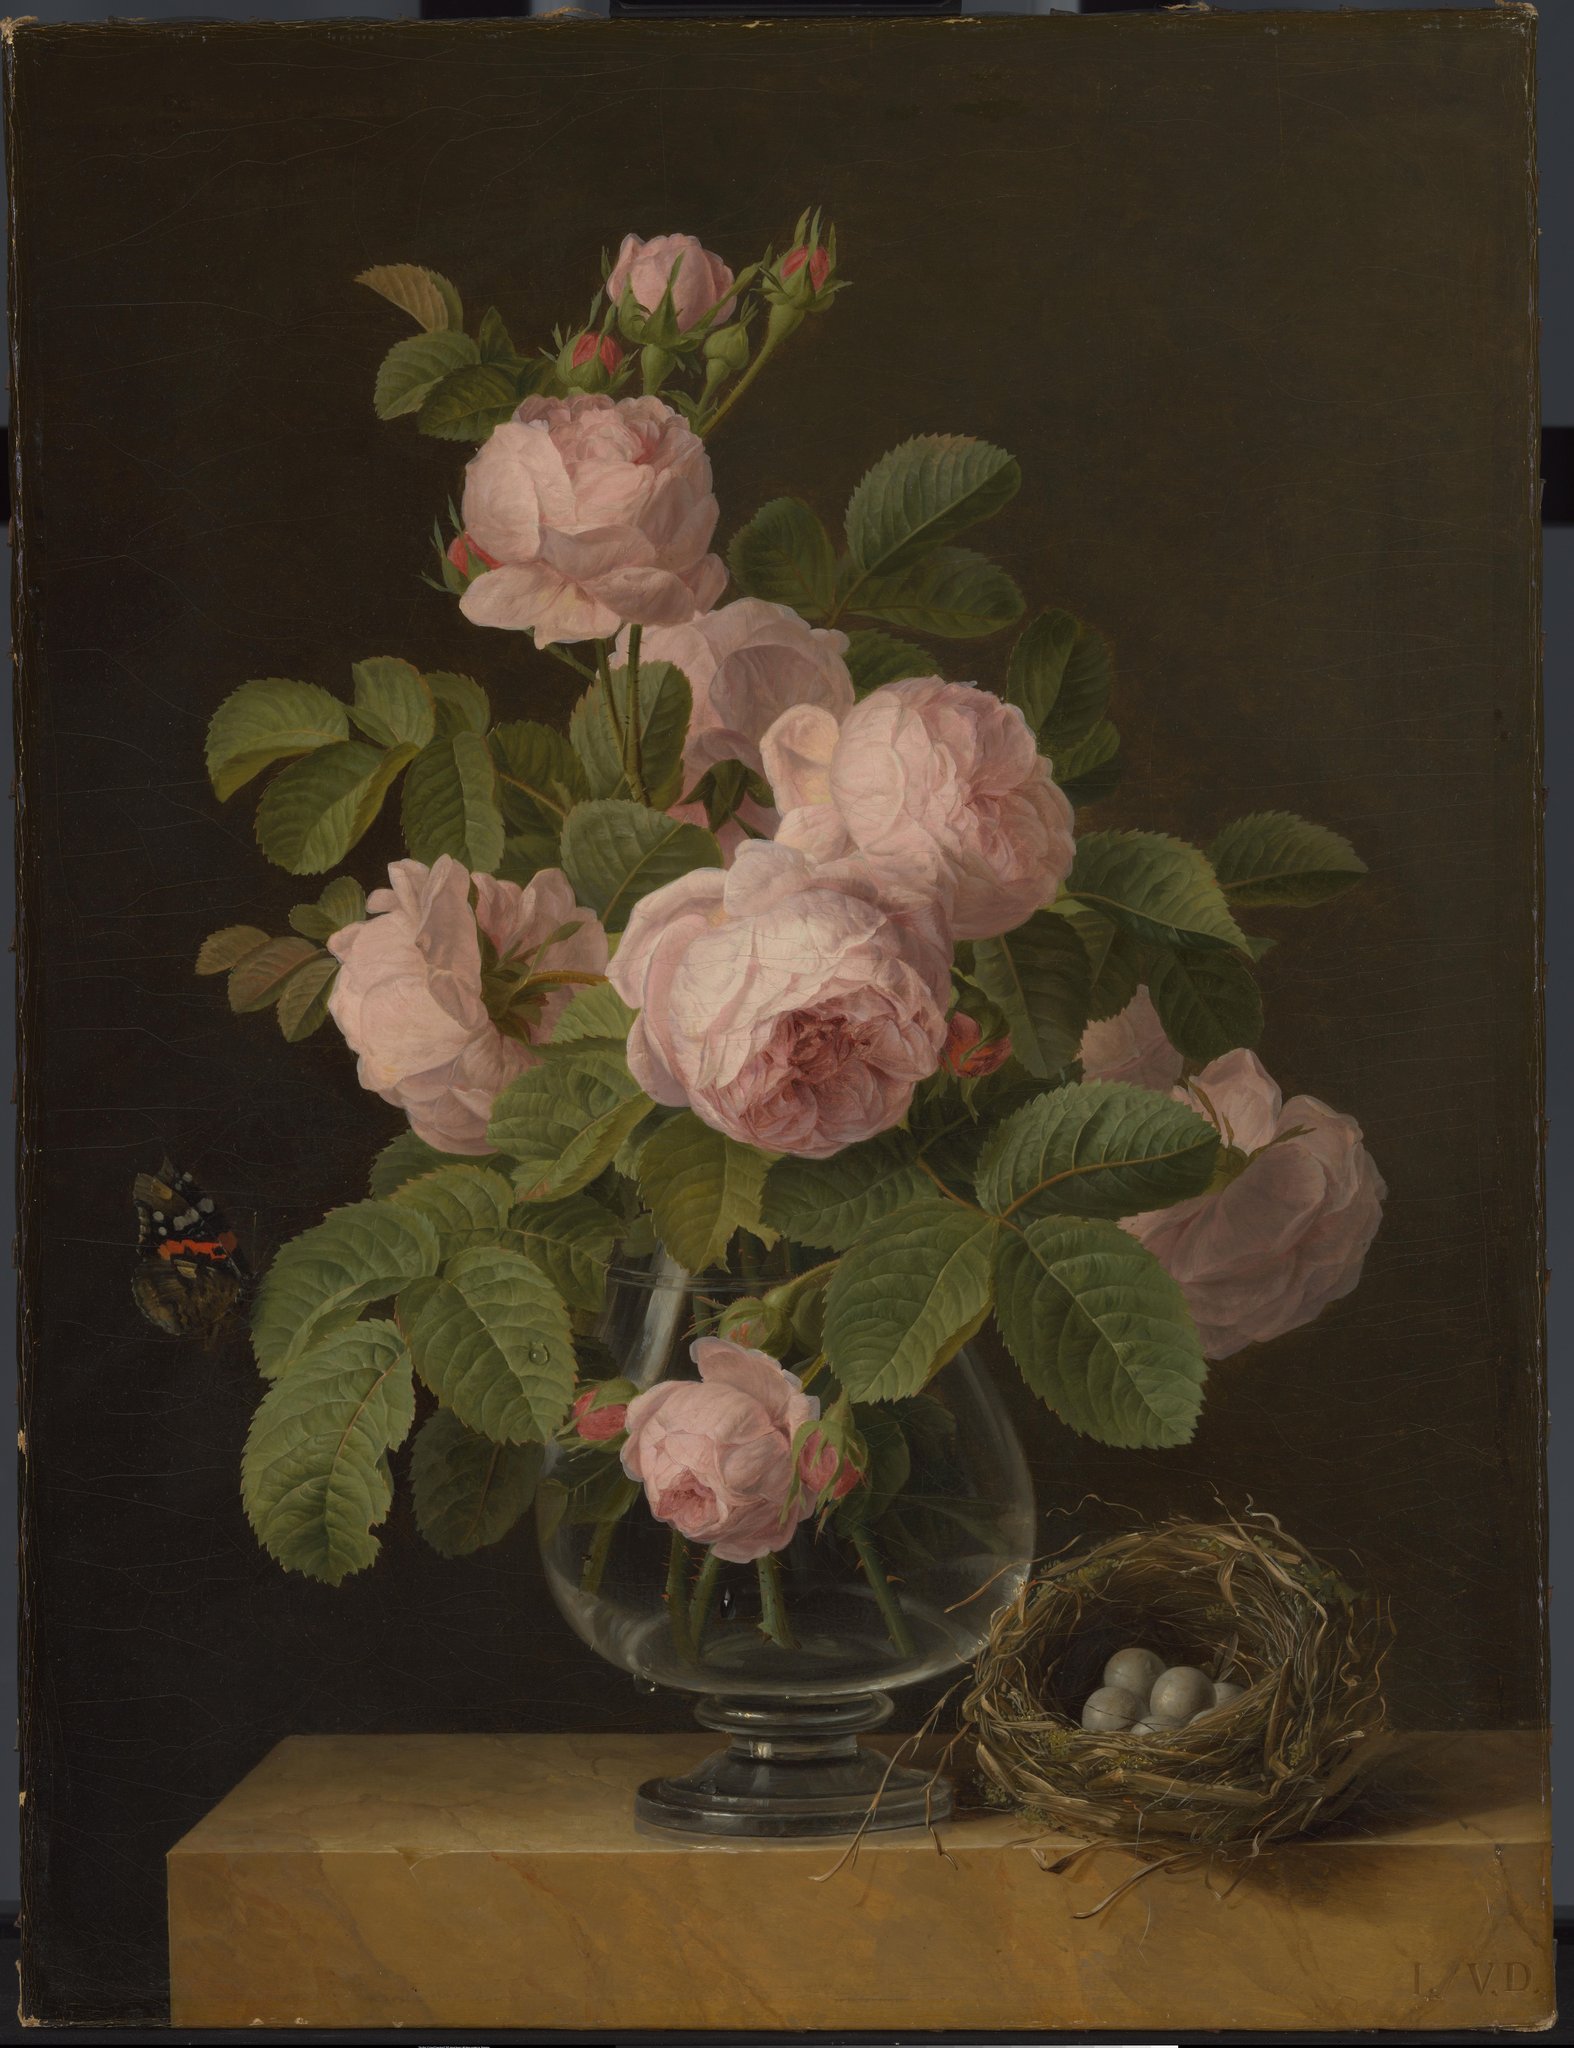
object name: painting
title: Stilleven met rozen en een vogelnestje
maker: jan frans van dael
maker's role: draughtsman, painter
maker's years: 1764-1840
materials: canvas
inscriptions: signature: ‘I.V.D.’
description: Rozen in een glazen vaas, op een marmeren plint, waarbij een vogelnestje met eieren.